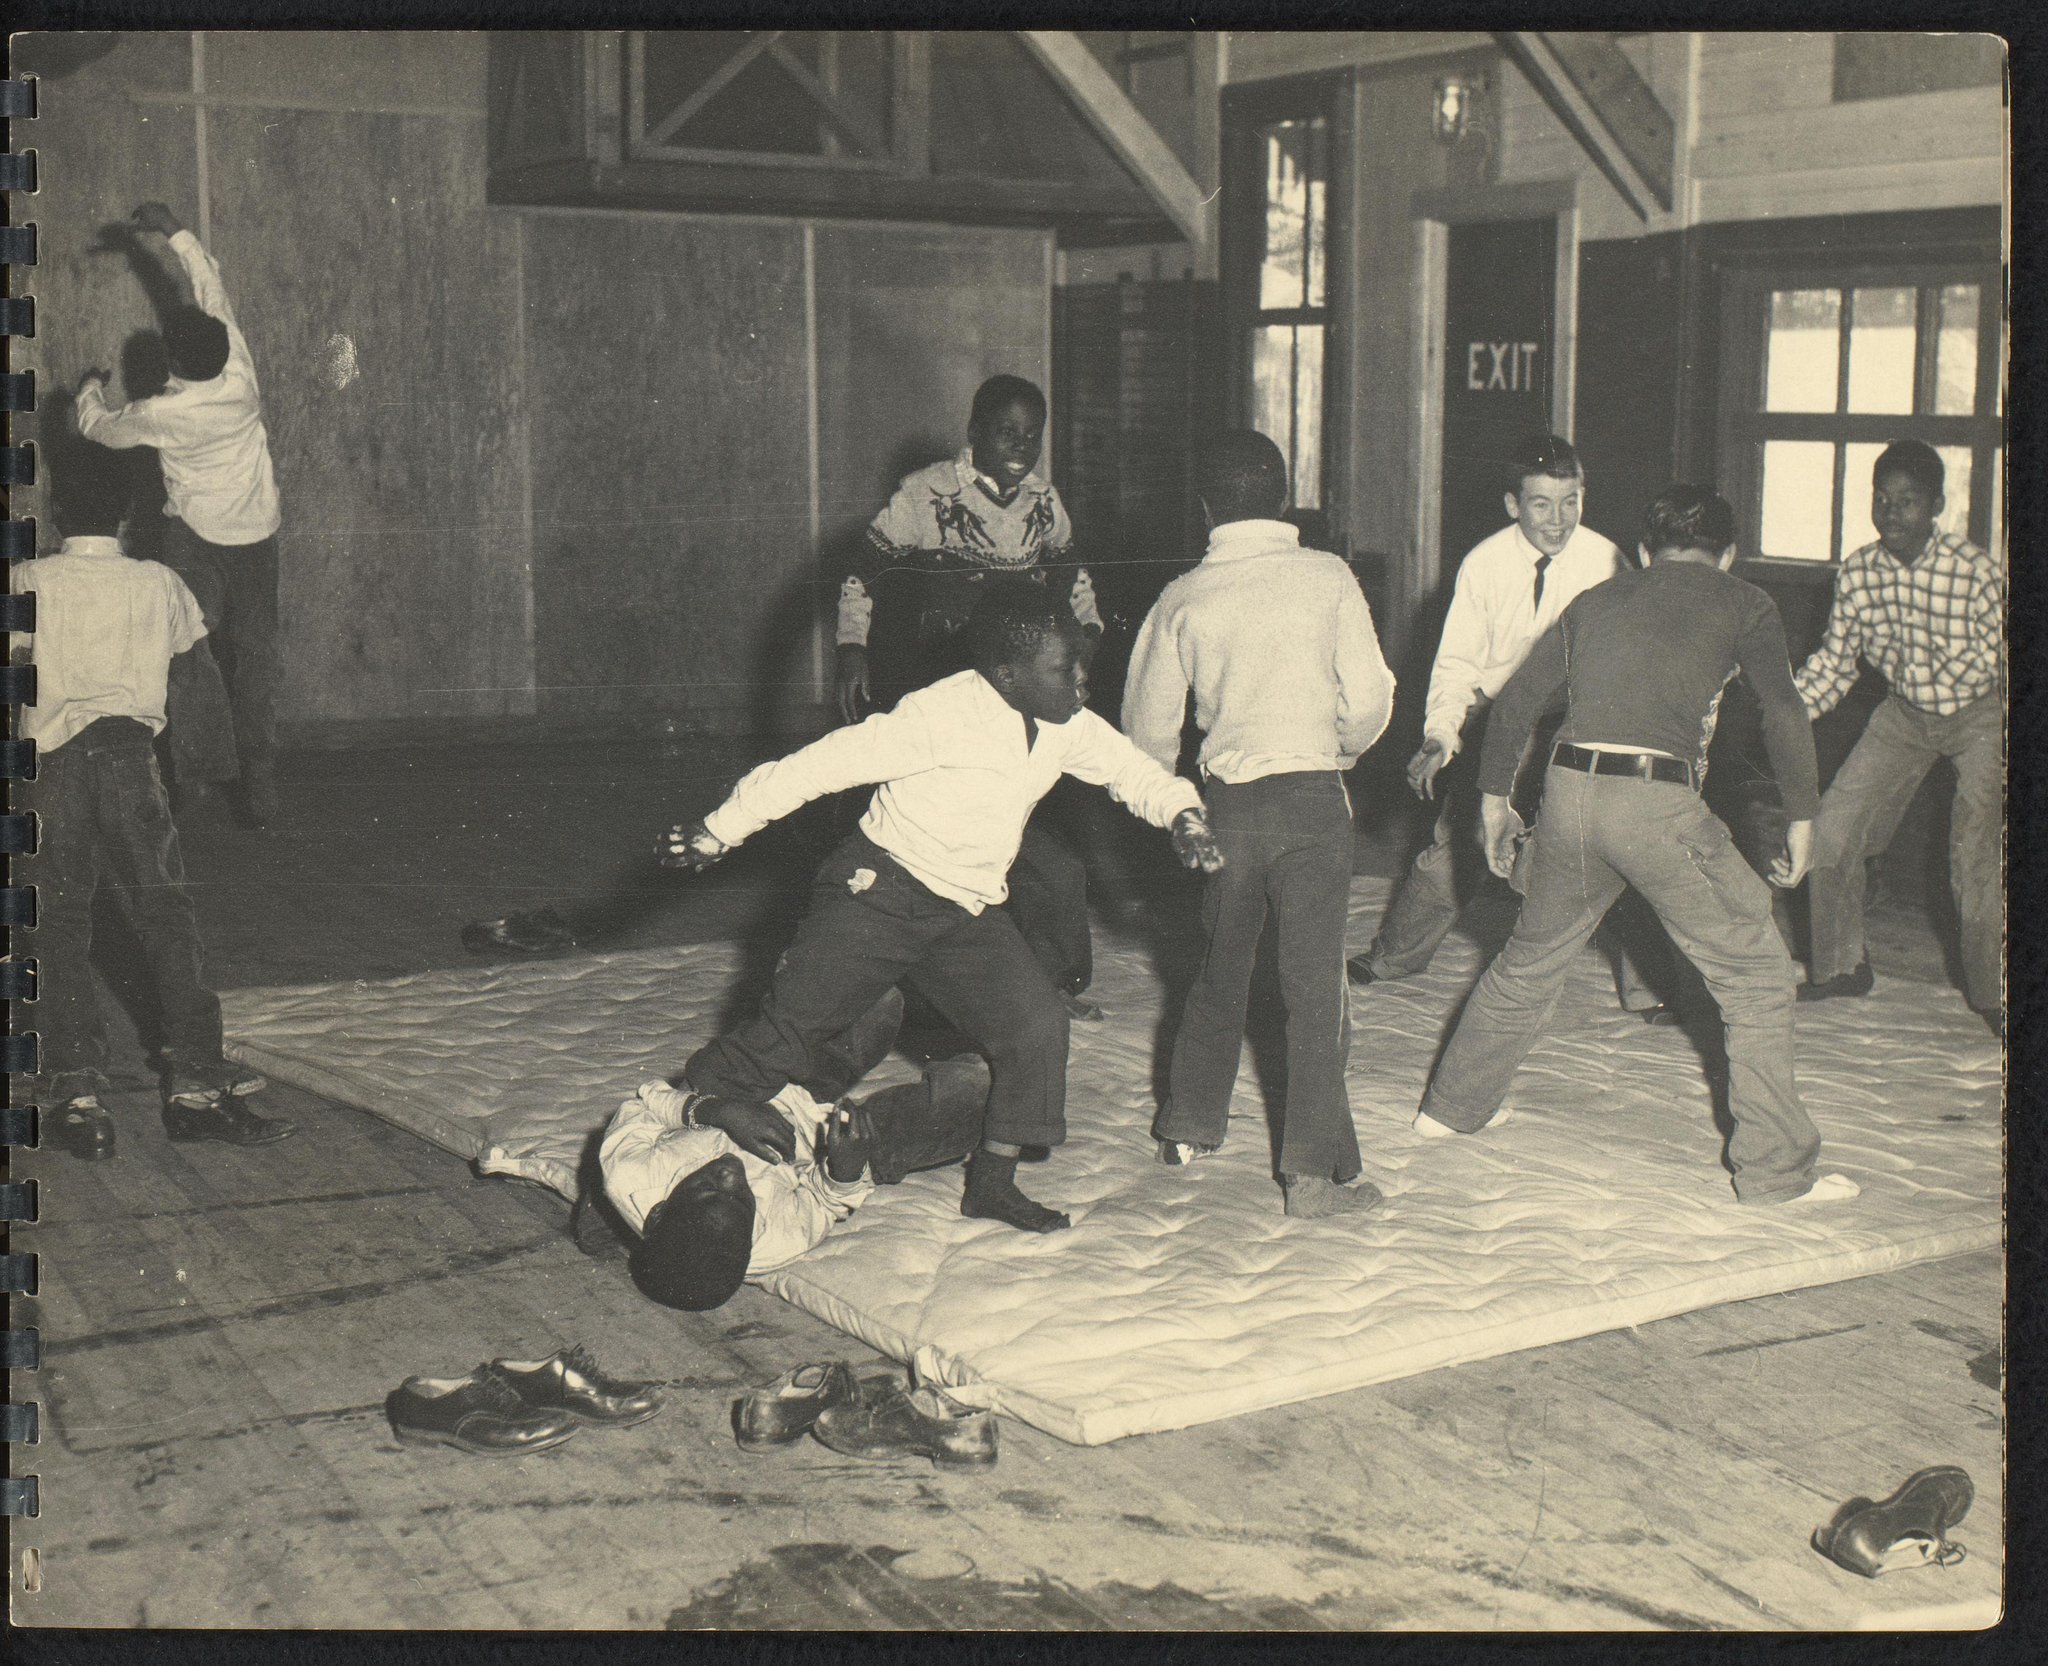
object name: photograph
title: Sportende jongens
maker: Anonymous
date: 1950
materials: paper, photographic support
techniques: gelatin silver print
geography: new york city